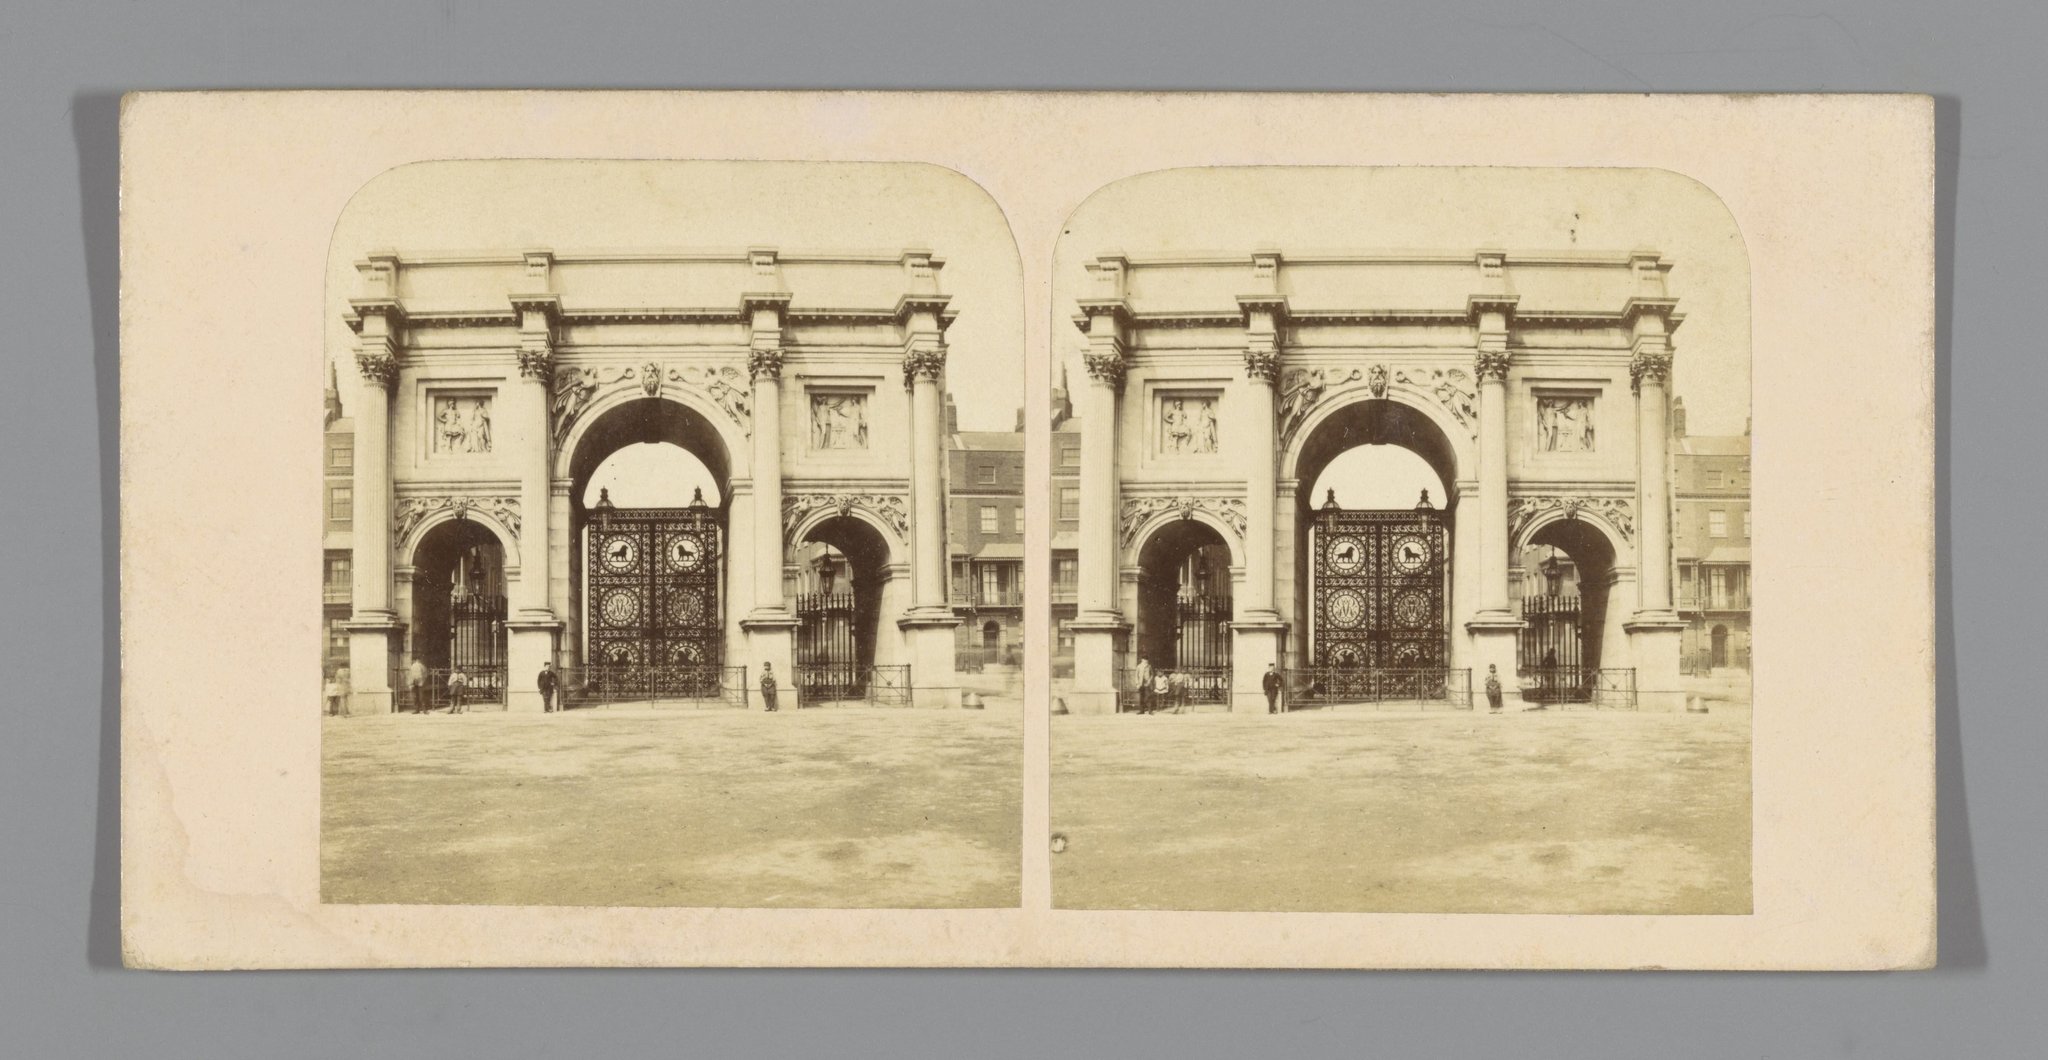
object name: stereograph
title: Views of London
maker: Anonymous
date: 1850-1880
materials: cardboard, photographic support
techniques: albumen print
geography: london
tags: triumphal arch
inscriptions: number: ‘53.’